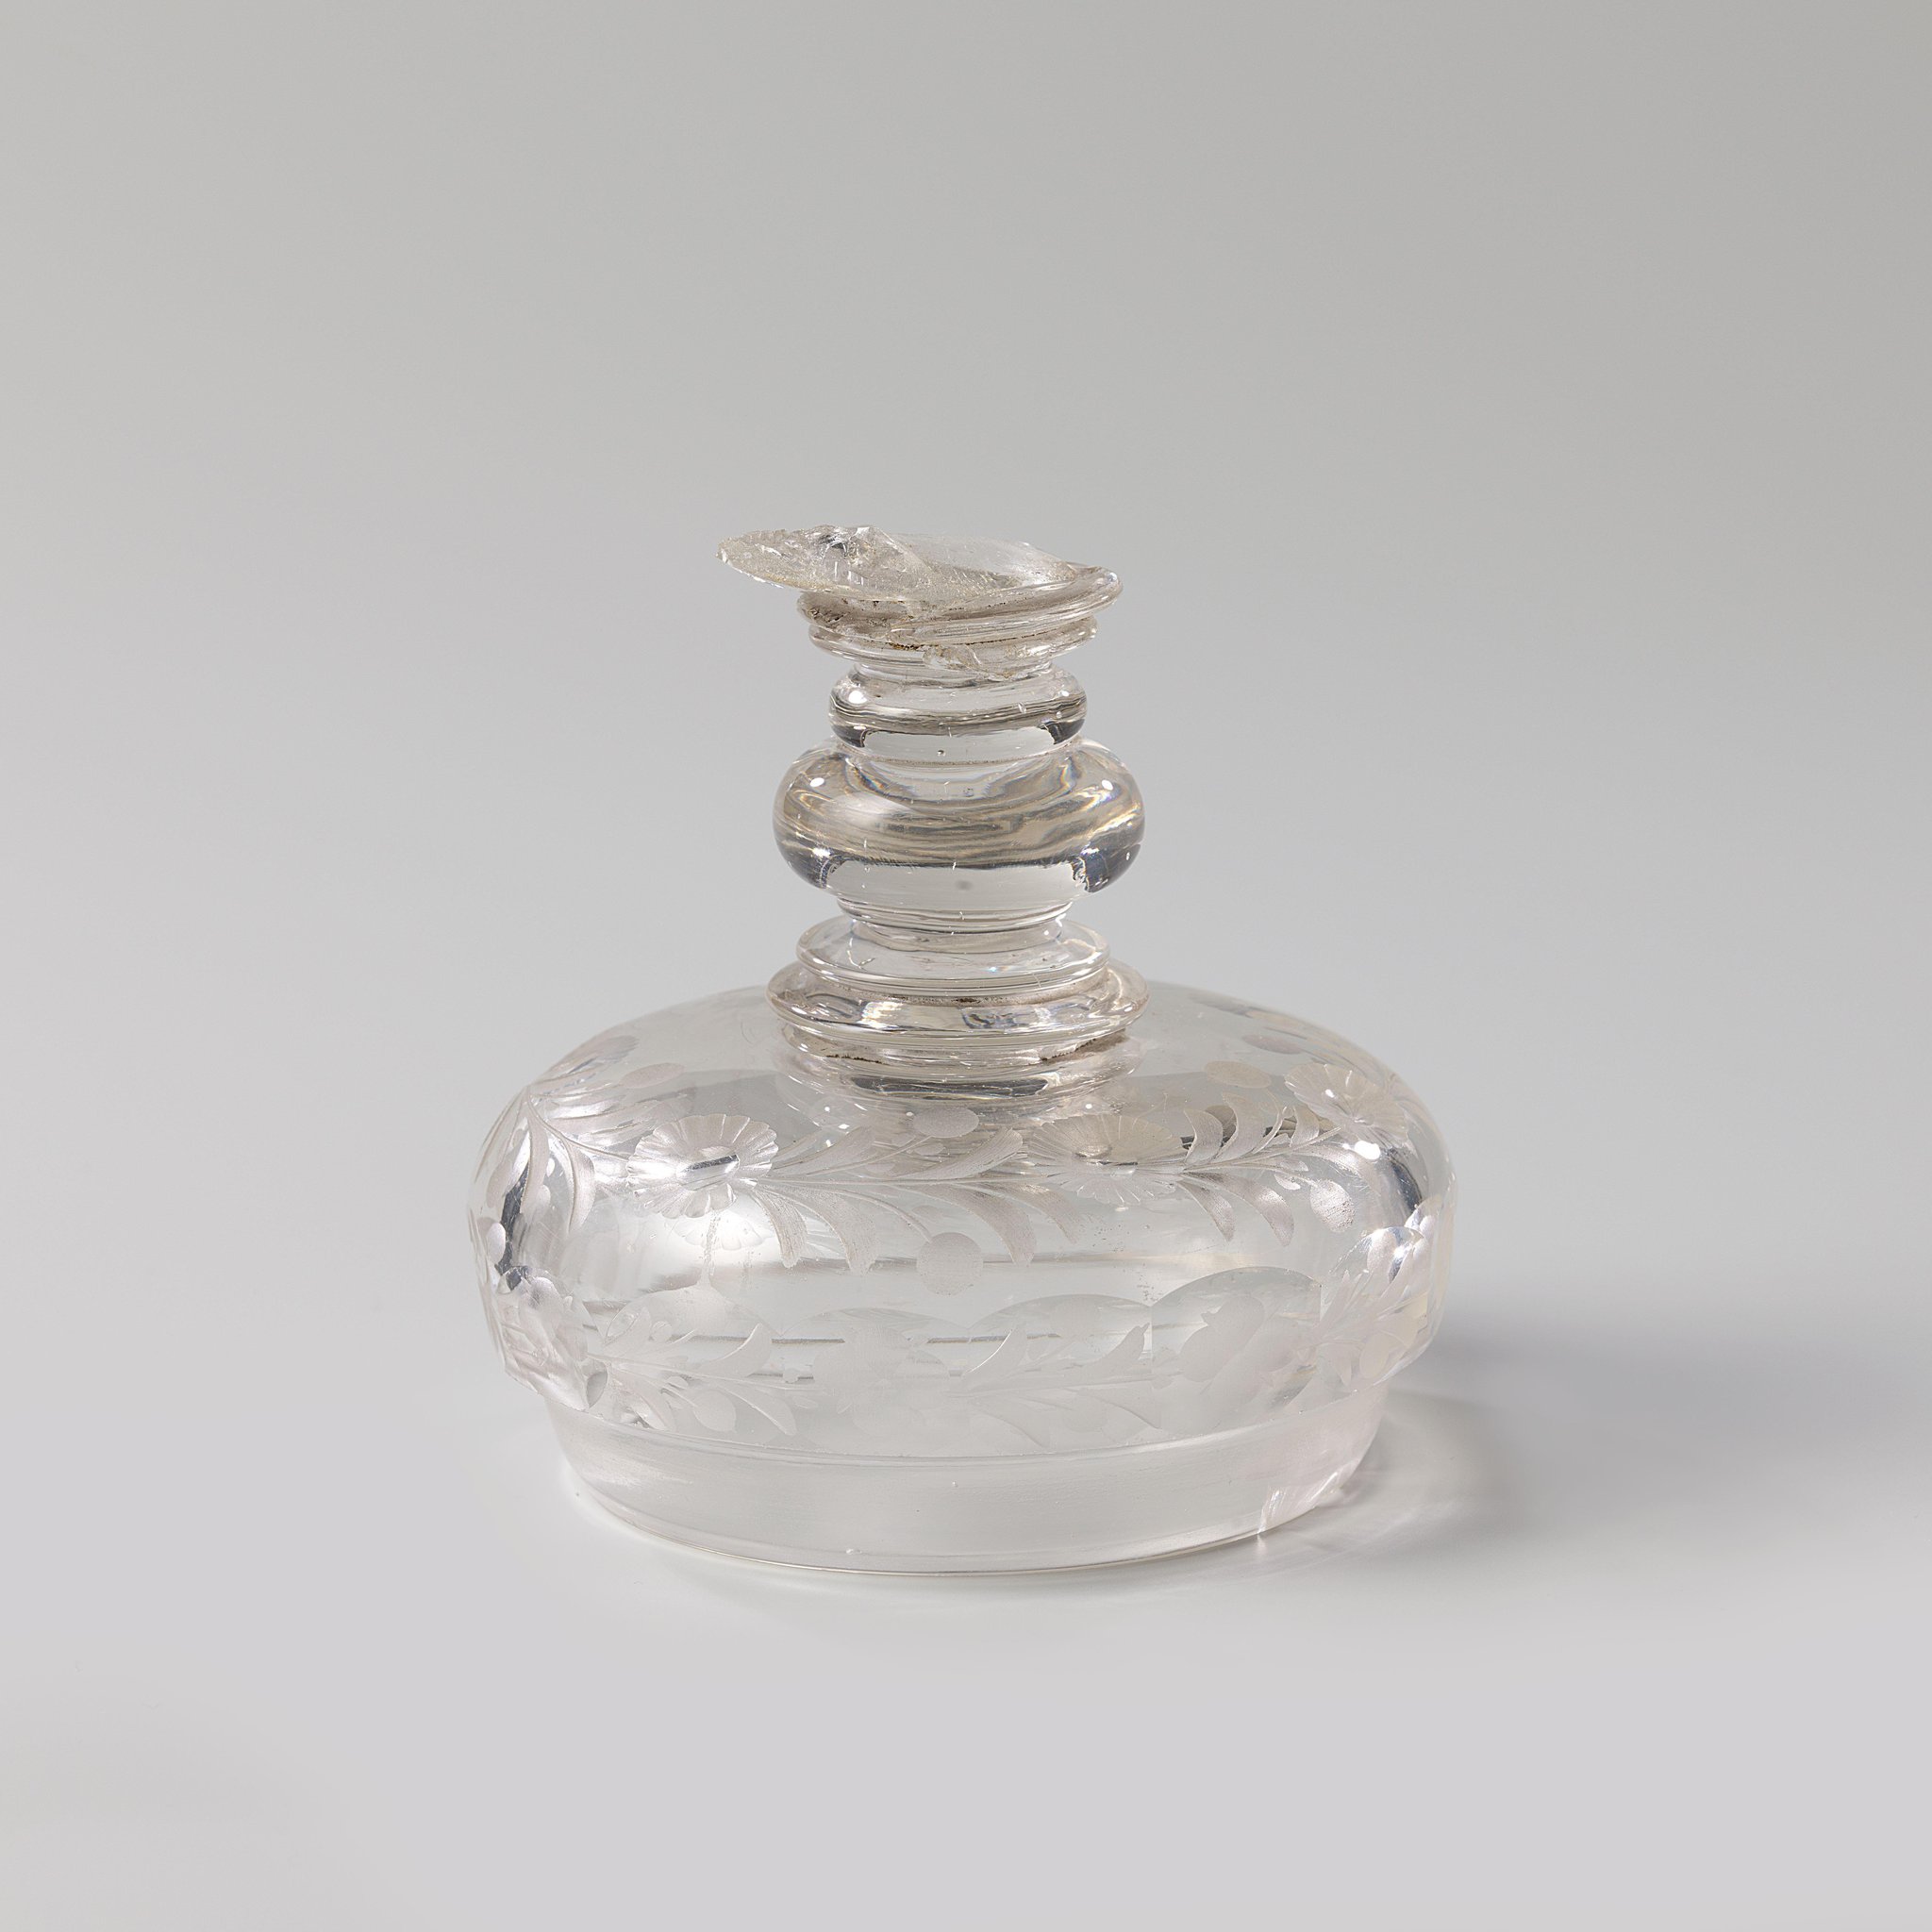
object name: lid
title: Deksel van een dubbelbokaal(?)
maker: Anonymous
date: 1725-1750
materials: glass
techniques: glassblowing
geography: netherlands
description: Gefacetteerde, gewelfde deksel, bekroond met gelede dekselknop, bestaande uit twee platte knopen en vijf schijven. Het uiteinde ontbrekt. Op de deksel rondlopend een gegraveerde bloemslinger.